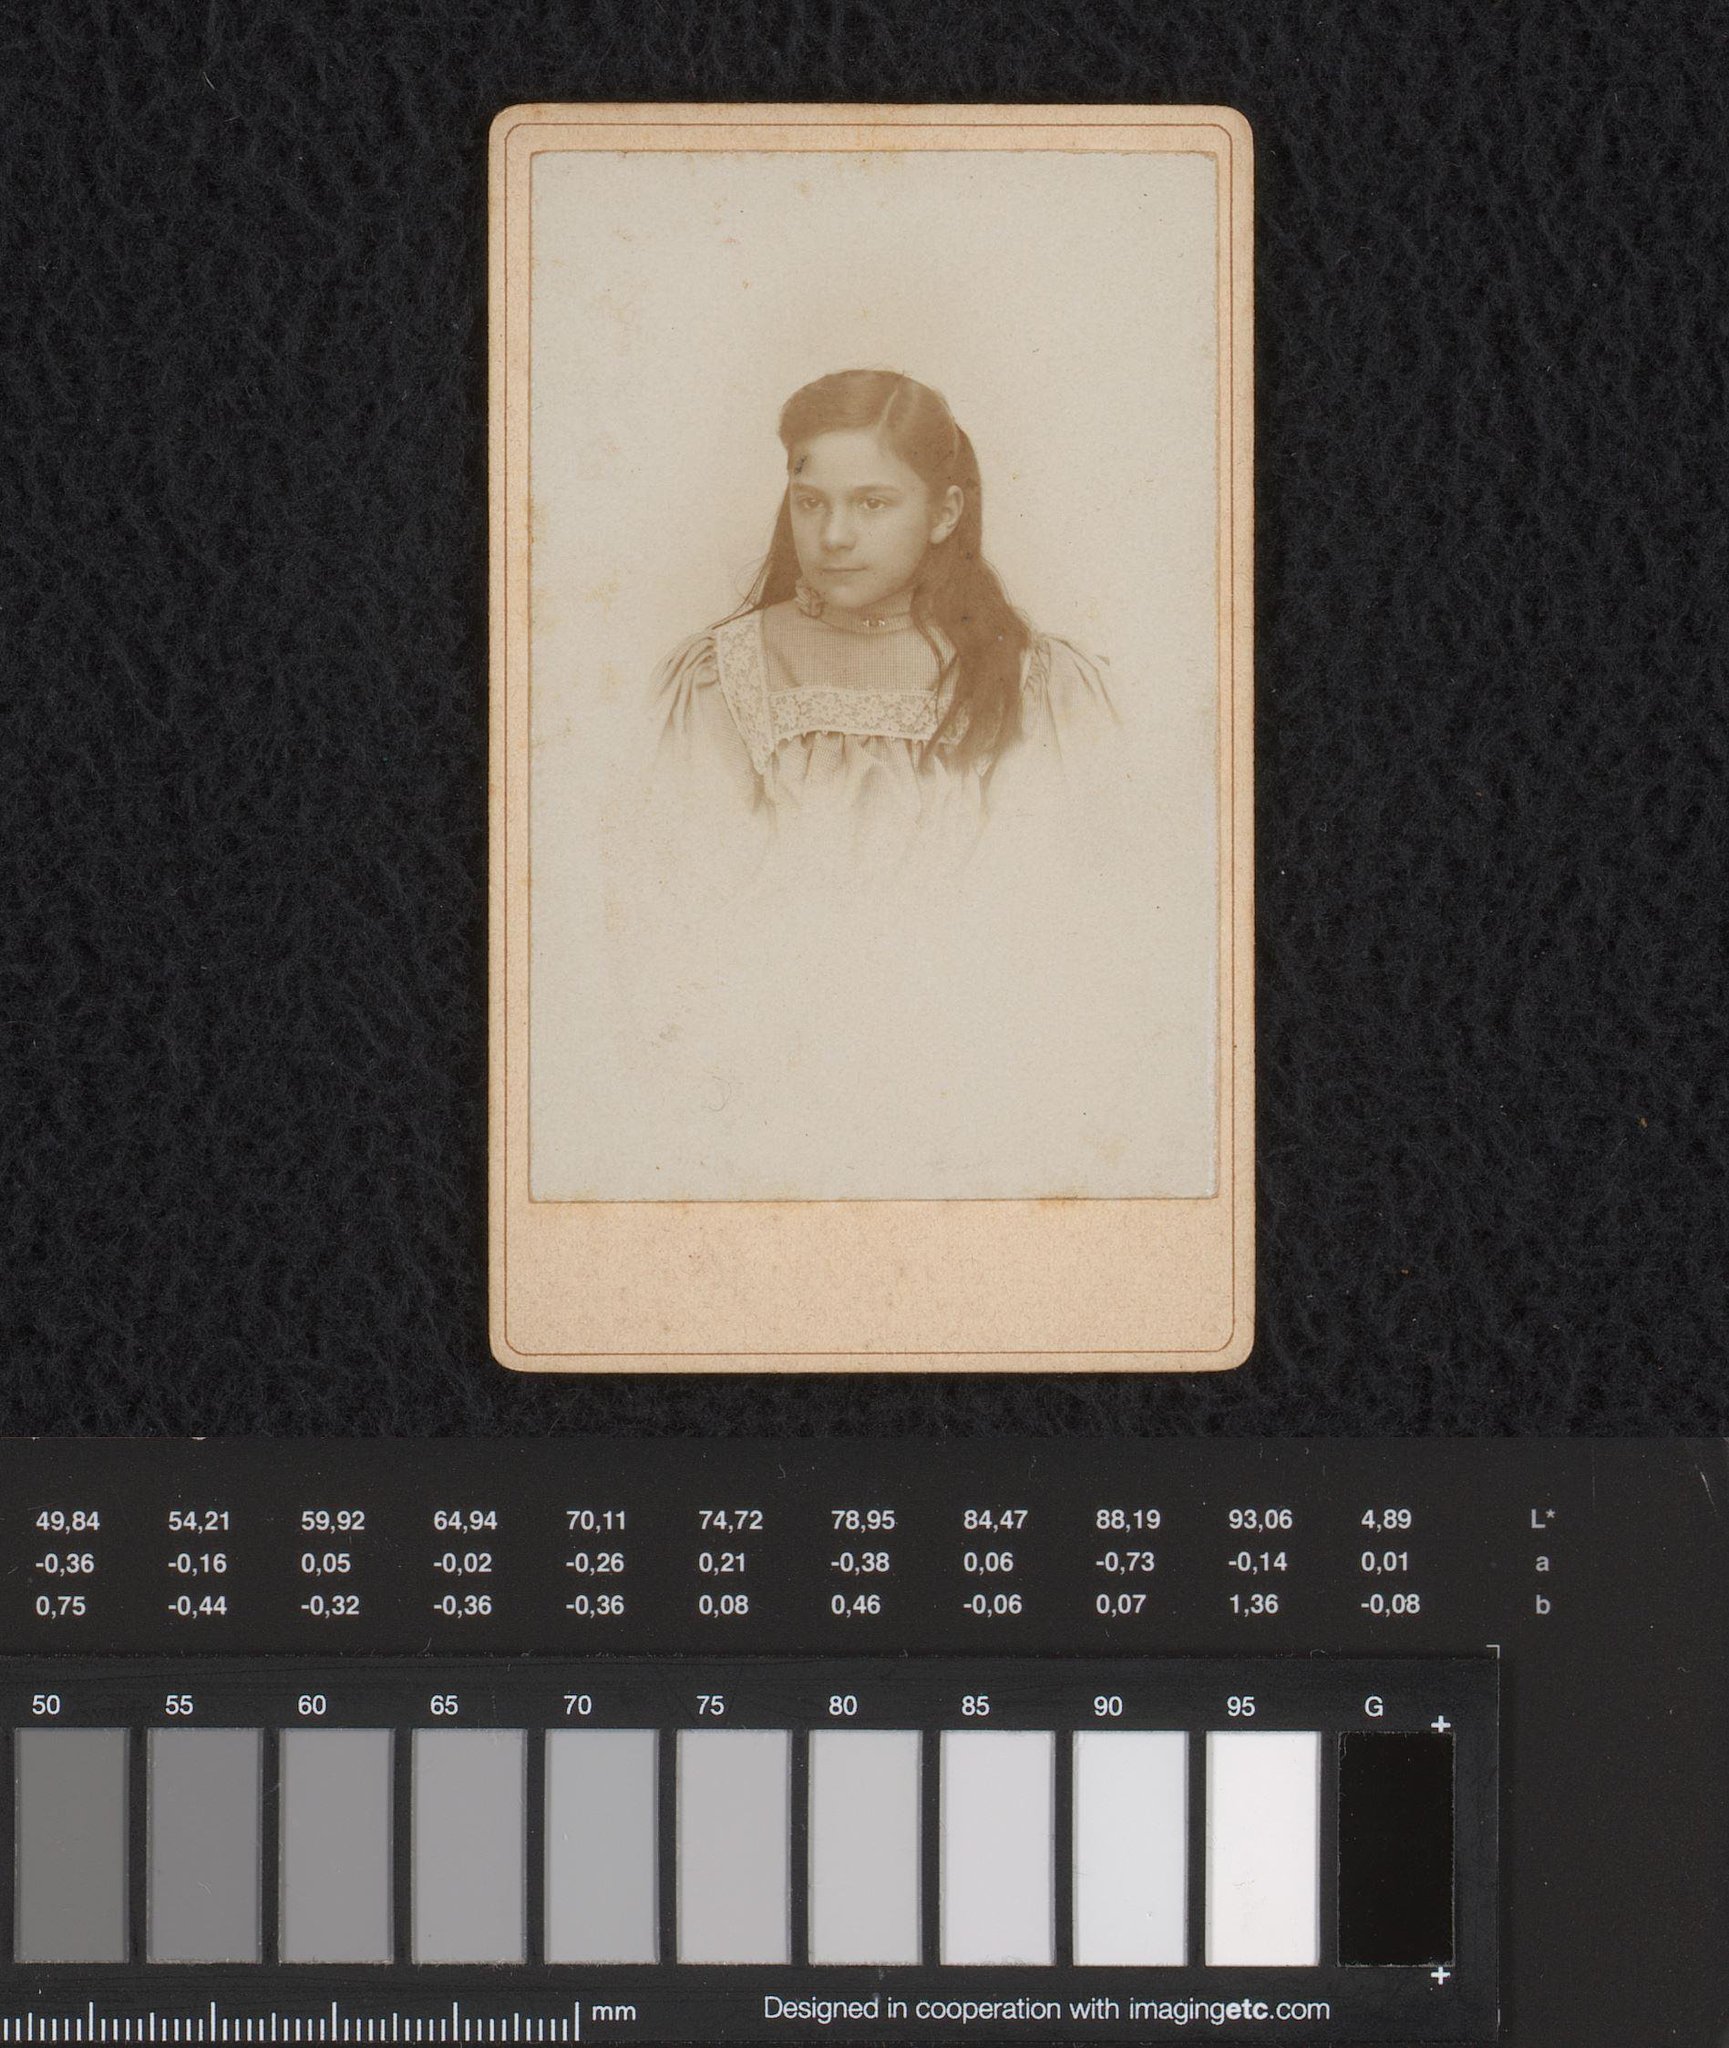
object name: photograph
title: Portret van Petronella Hermina Bon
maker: coenraad jacob snooij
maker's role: publisher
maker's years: 1874-1972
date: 1893-1900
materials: paper, cardboard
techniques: collodion silver print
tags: historical persons - bb - woman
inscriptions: inscription: ‘Tante Nel als/ jong meisje’